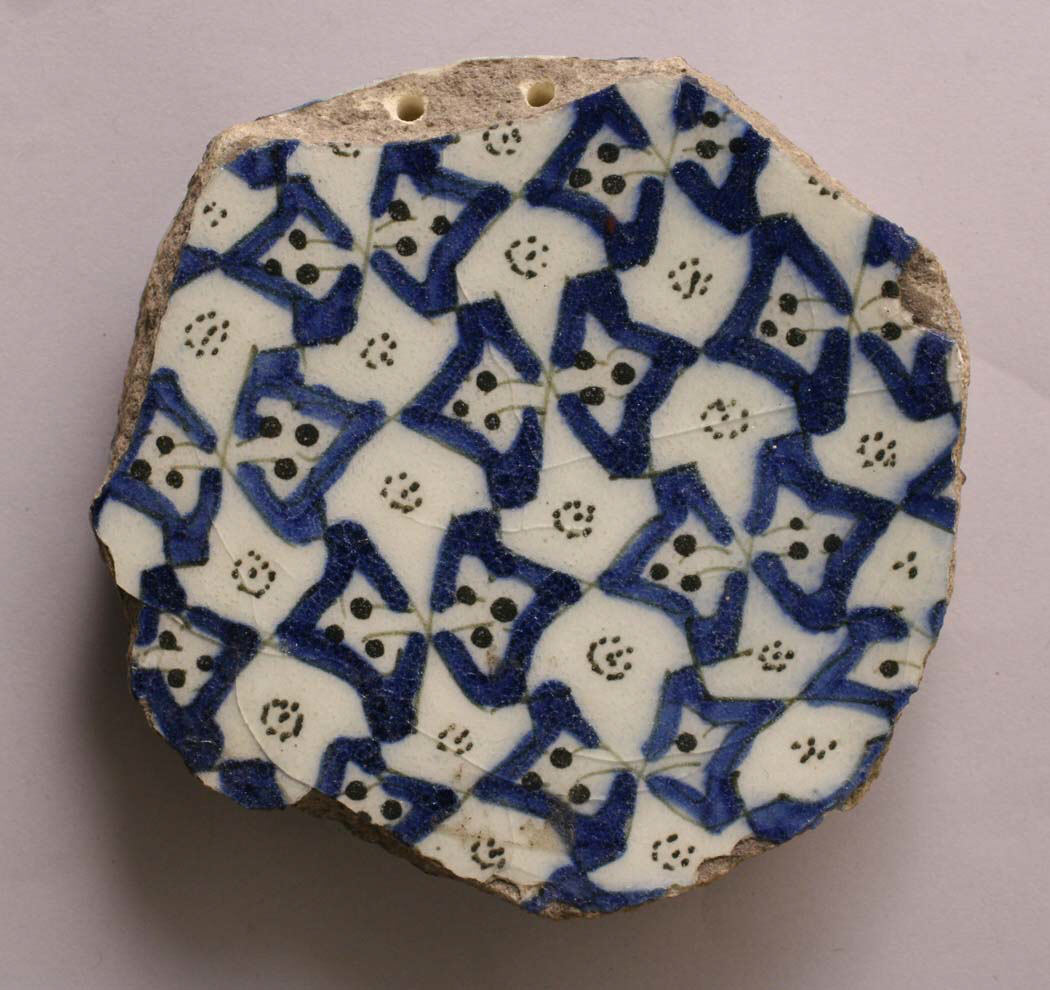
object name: fragment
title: Fragment of a Bowl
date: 1301-1400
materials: glaze, stonepaste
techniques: painting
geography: egypt or syria